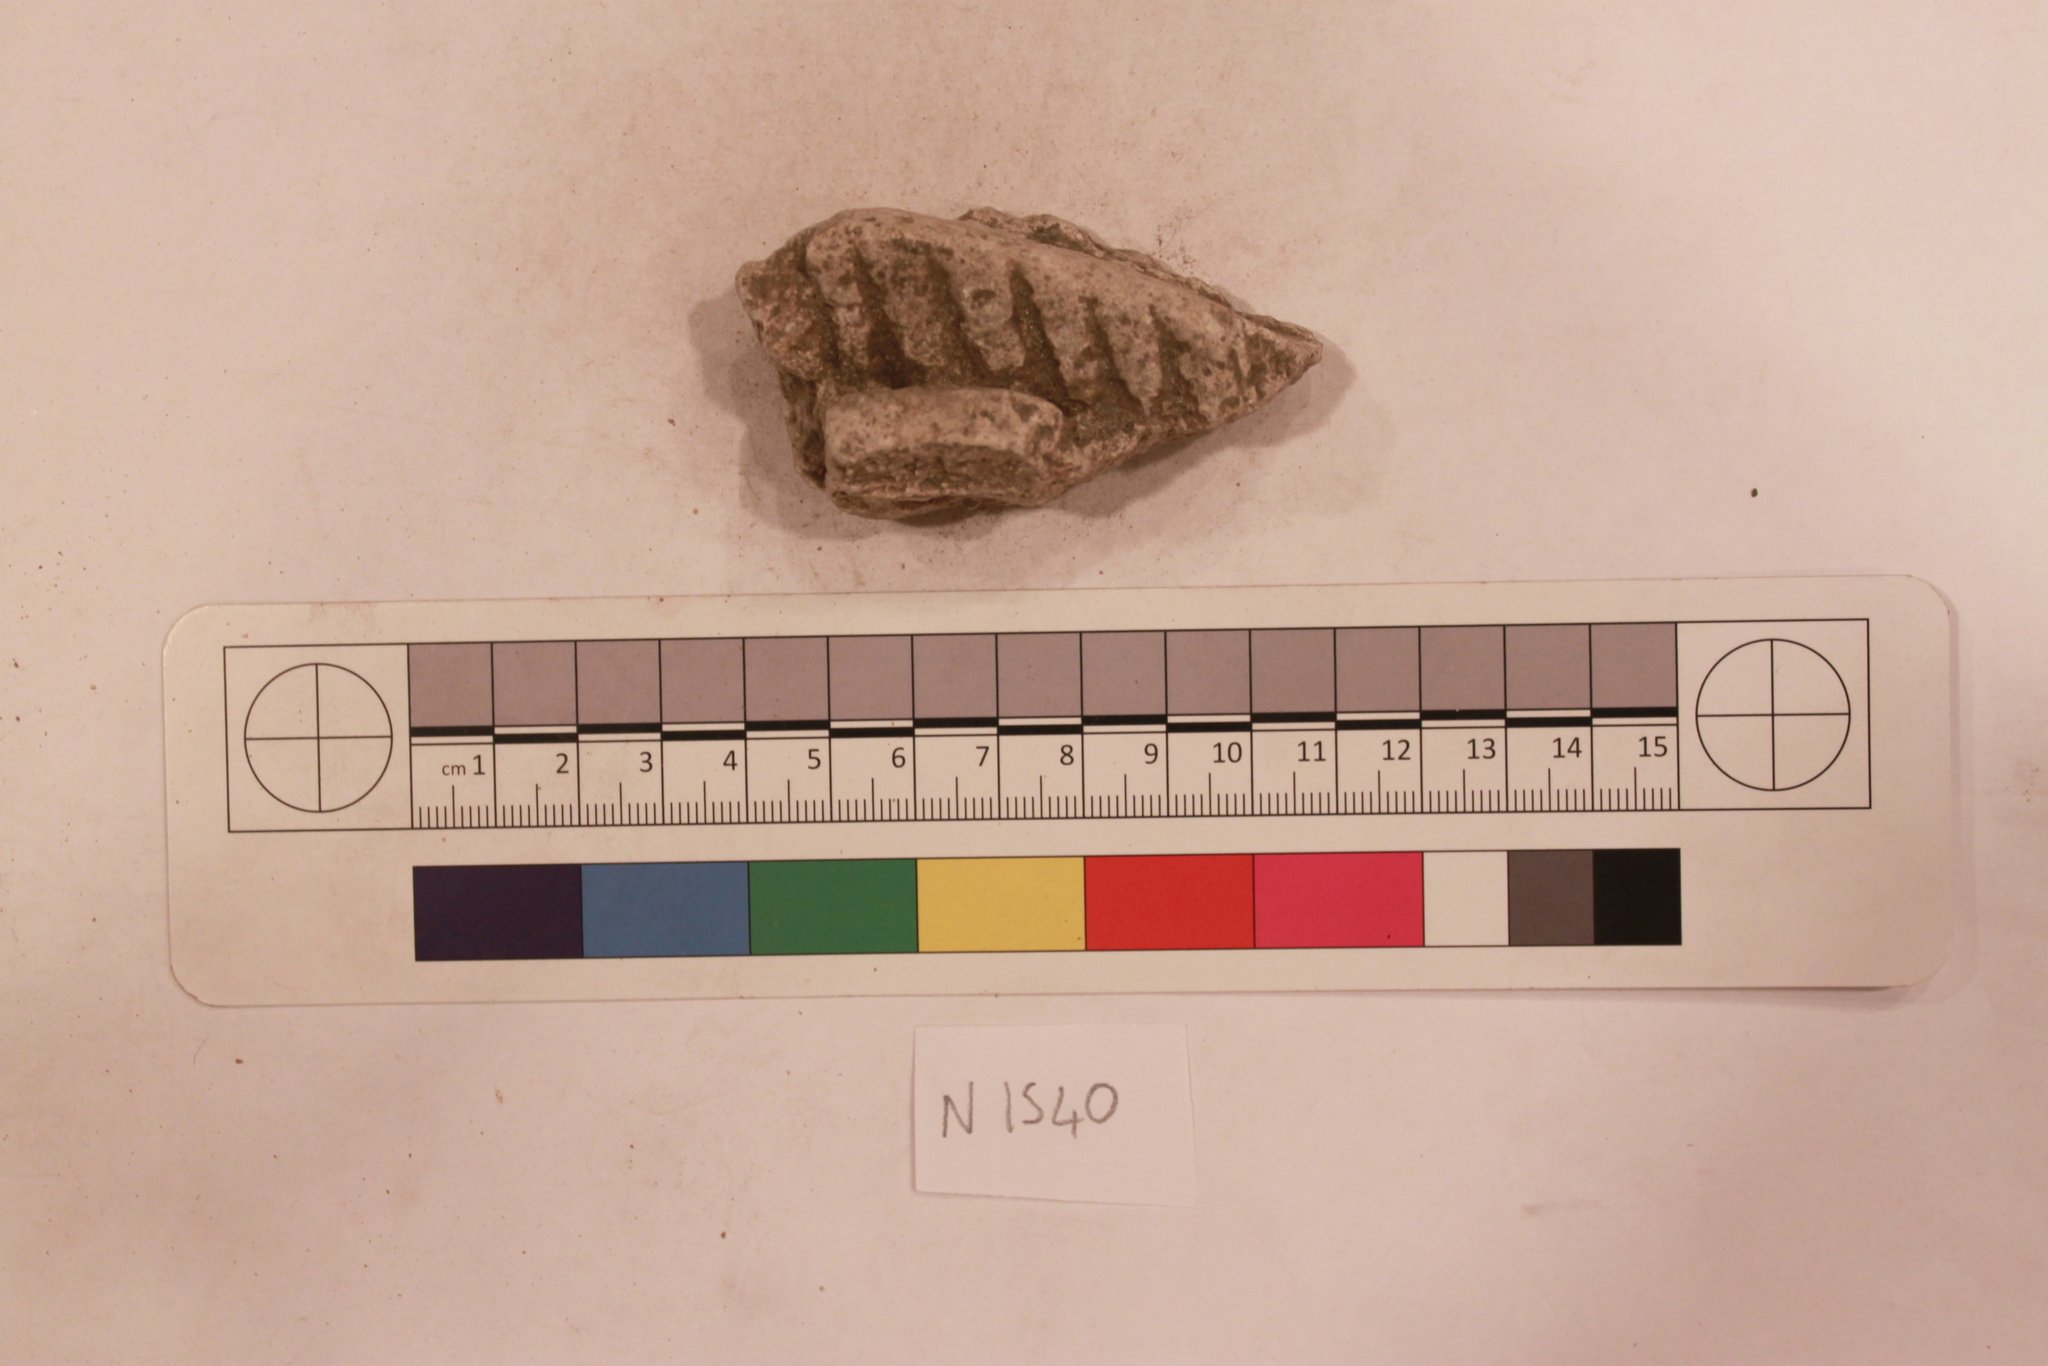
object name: fragment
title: Stucco Fragment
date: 701-1200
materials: plaster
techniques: carving, painting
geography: iran